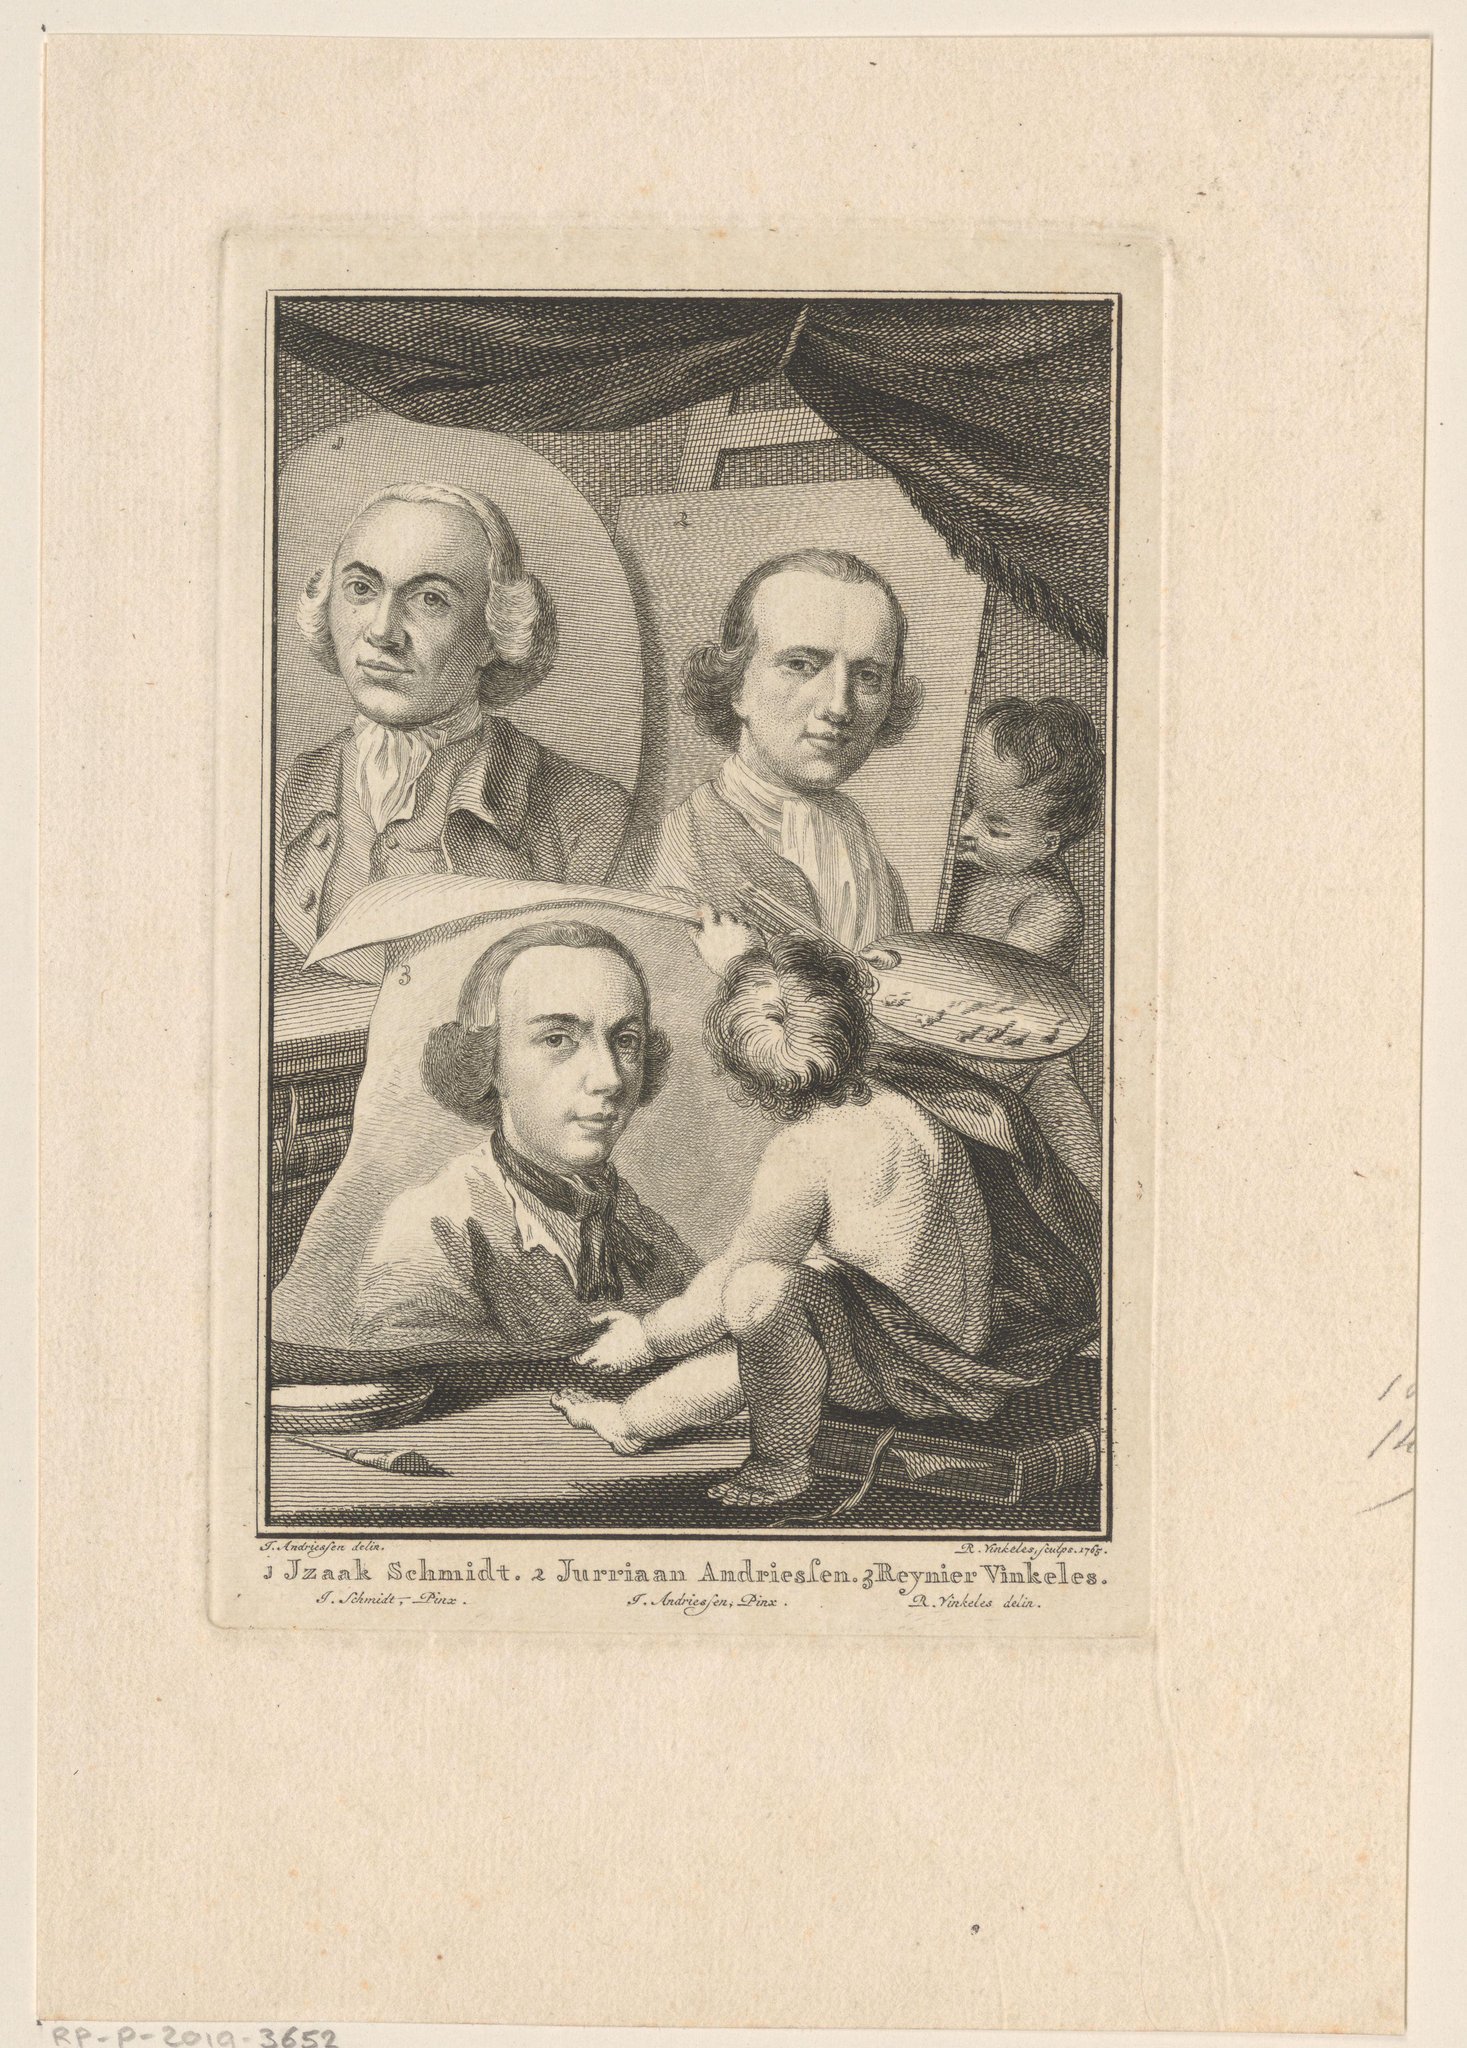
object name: print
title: Portretten van Izaak Schmidt, Jurriaan Andriessen en Reinier Vinkeles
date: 1765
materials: paper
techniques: engraving, etching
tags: painter, jurriaan andriessen, amsterdam, print maker, draughtsman, izaak schmidt, reinier vinkeles (i), historical persons, portrait, self-portrait of artist, cupids: 'amores', 'amoretti', 'putti'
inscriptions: collector's mark: Lugt 2228